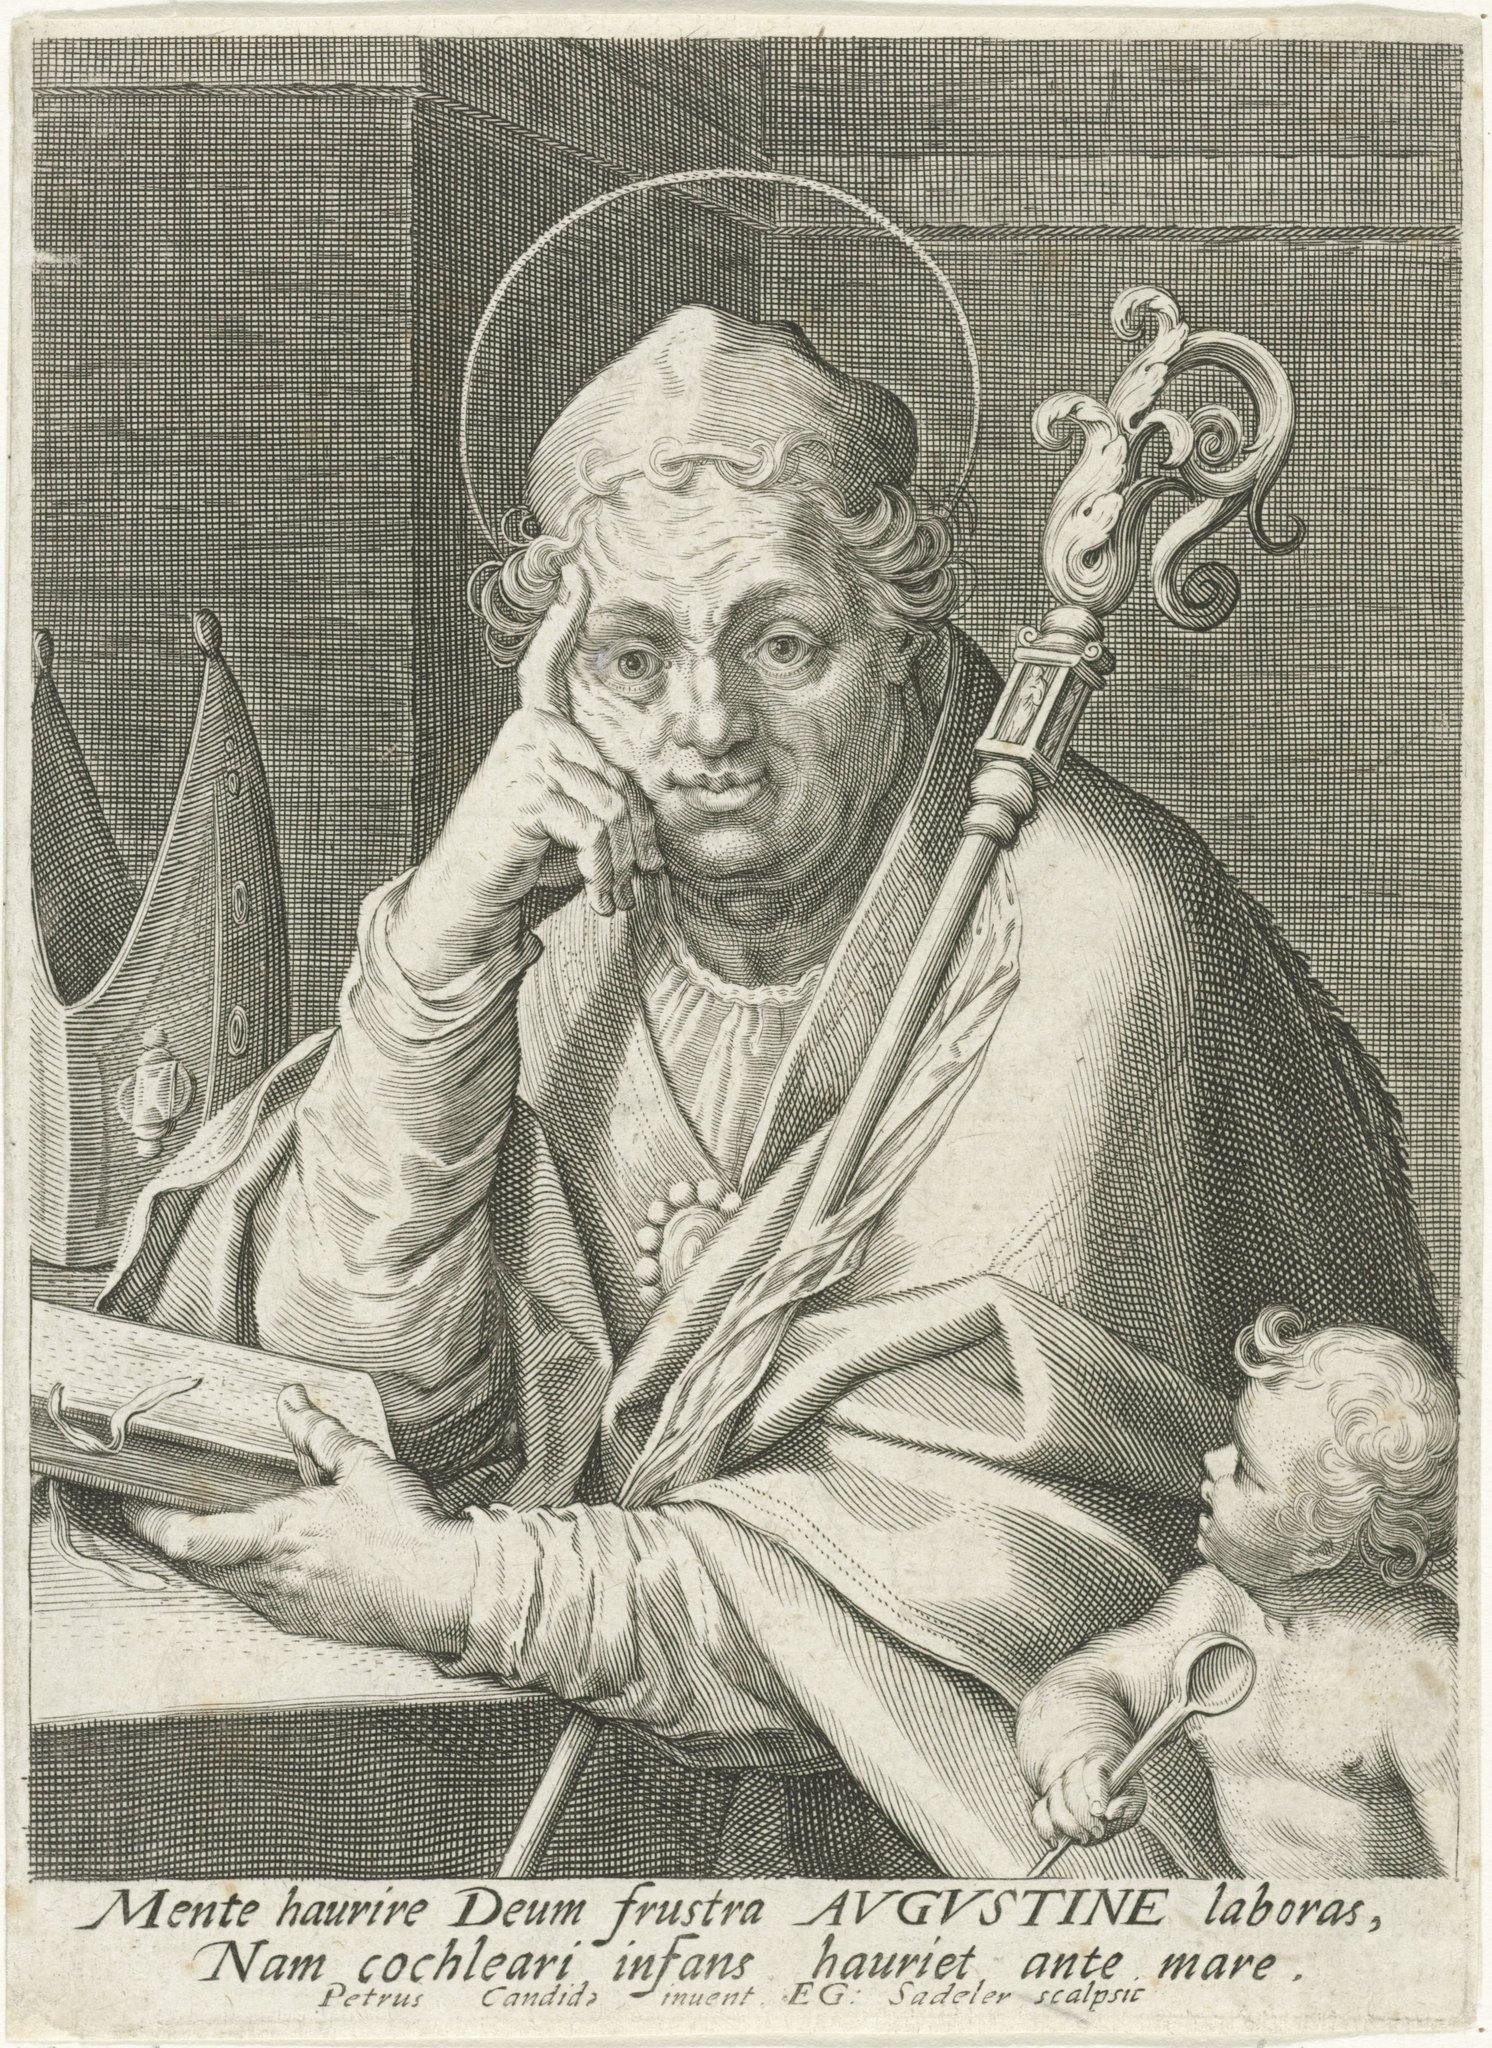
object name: print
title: Kerkvader Augustinus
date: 1580-1629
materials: paper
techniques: engraving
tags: st. augustine as doctor of the latin church in his study, at his writing-desk, with book, pen and sometimes a dove (divine inspiration)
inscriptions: collector's mark: Lugt 240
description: De H. Augustinus, bisschop van Hippo. Hij draagt het bisschopsgewaad en zijn mijter ligt naast hem op een tafel. Naast Augustinus een kind met een lepel. De prent heeft een Latijns onderschrift.